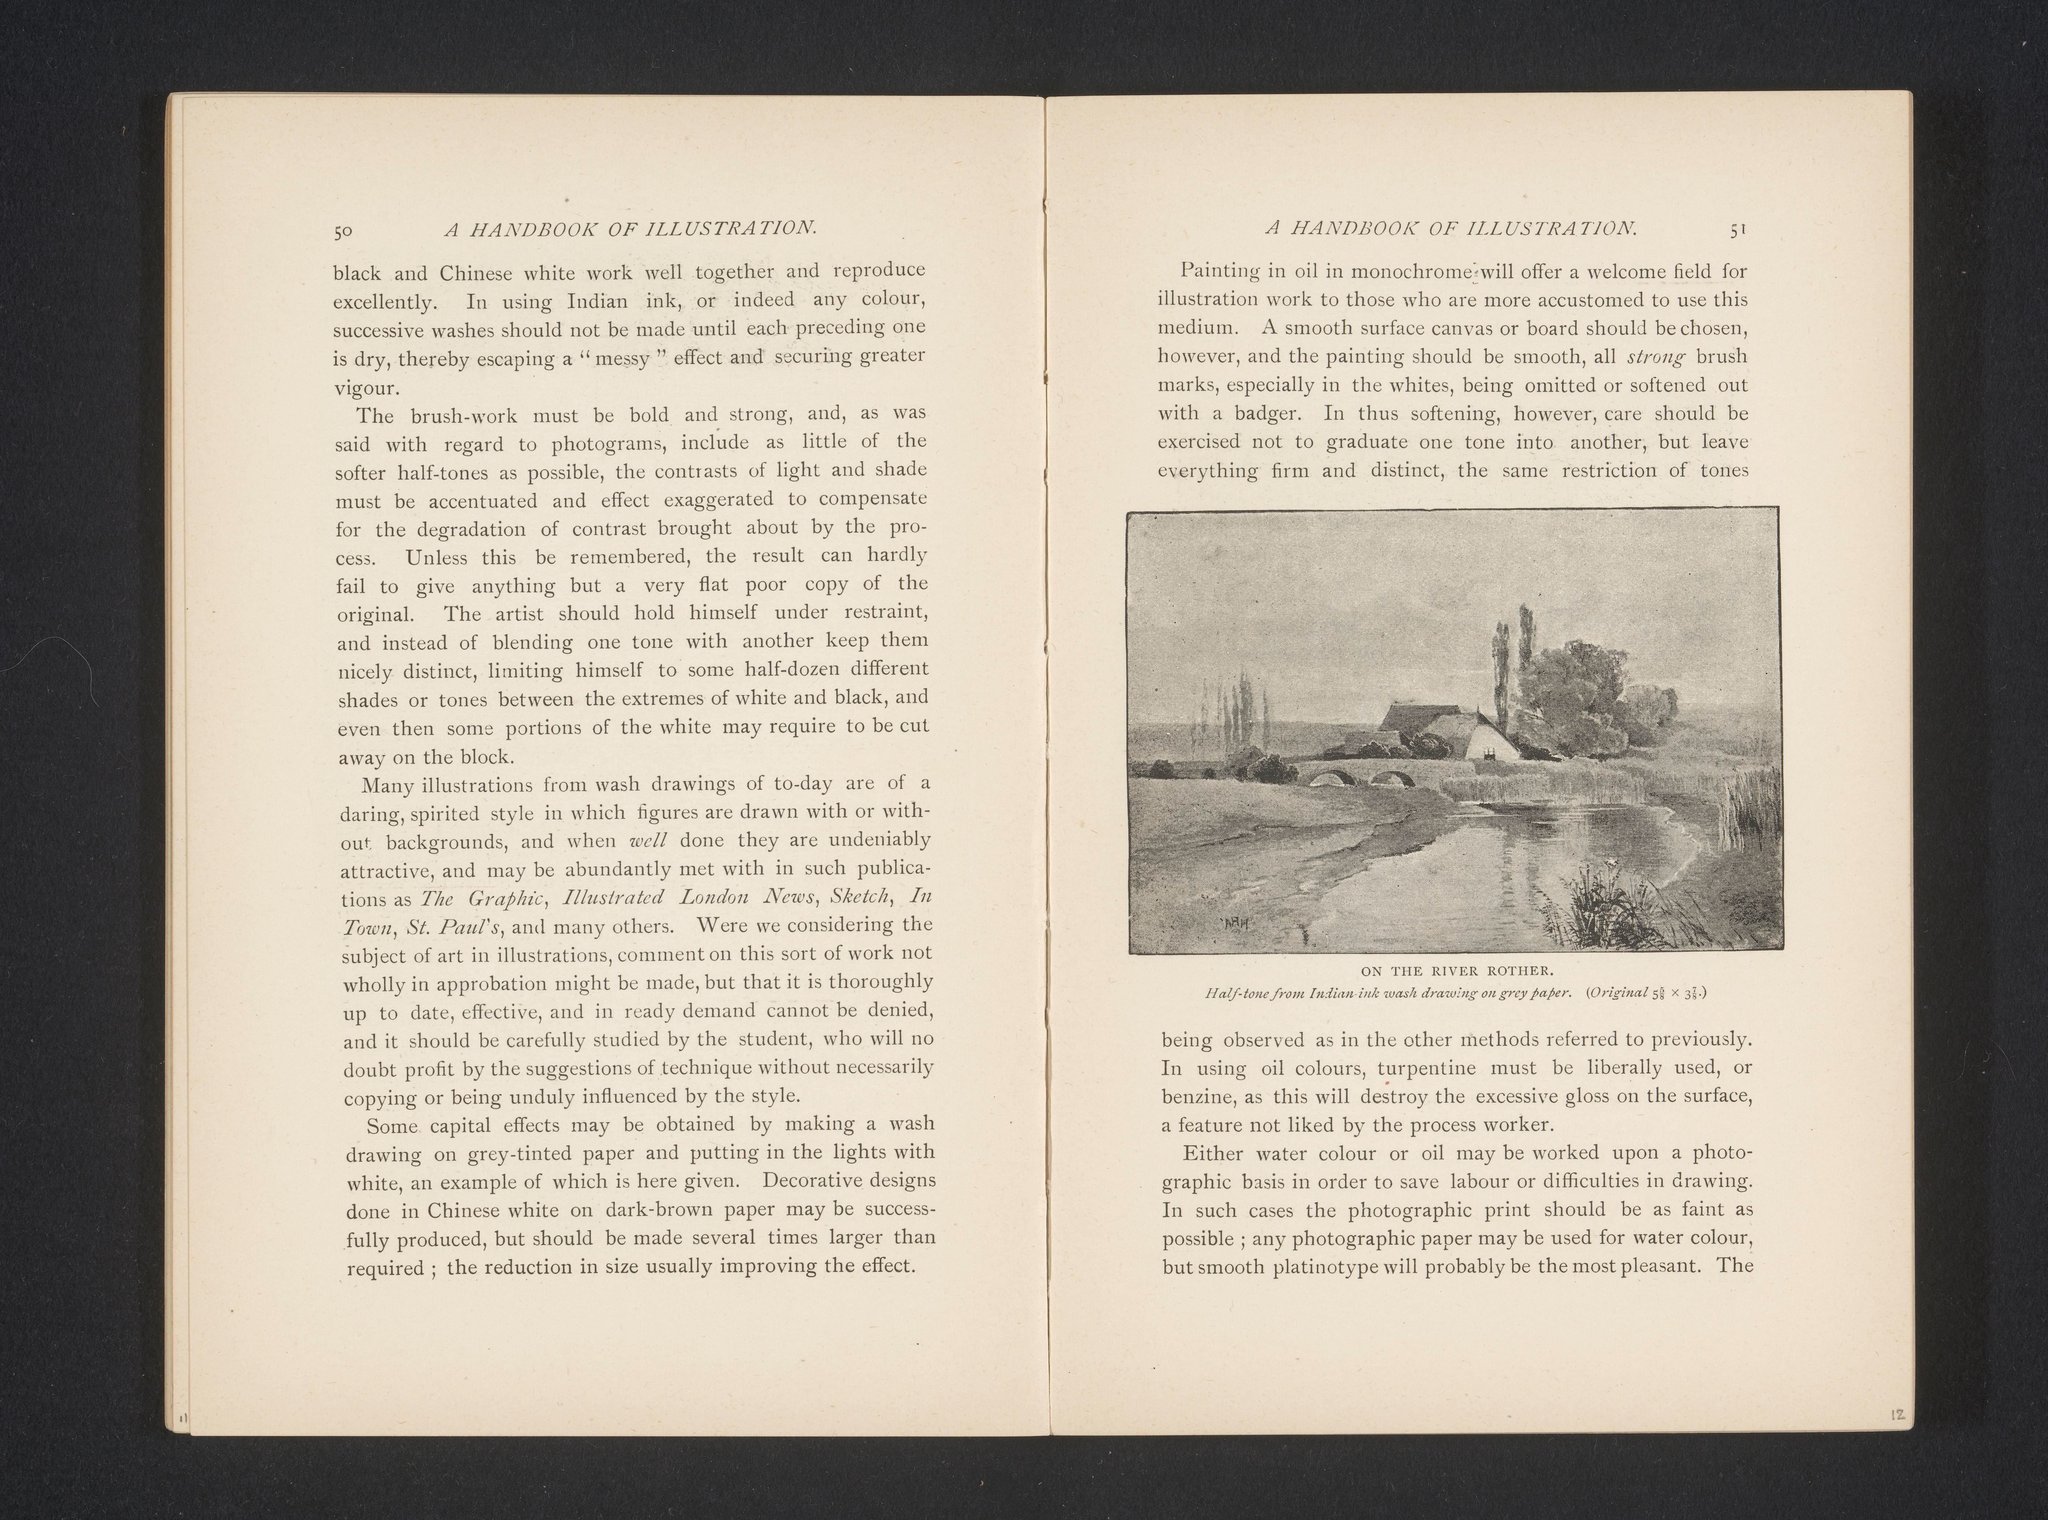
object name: reproduction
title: Fotoreproductie van een tekening van een huis en een brug aan de rivier de Rother in Engeland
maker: Anonymous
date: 1884-1894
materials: paper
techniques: autotype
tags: river, bridge, england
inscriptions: inscription: ‘Half-tone from Indian-ink wash drawing on grey paper. (Original 5 5/8 x 3 7/8.)’, name: ‘AAH’